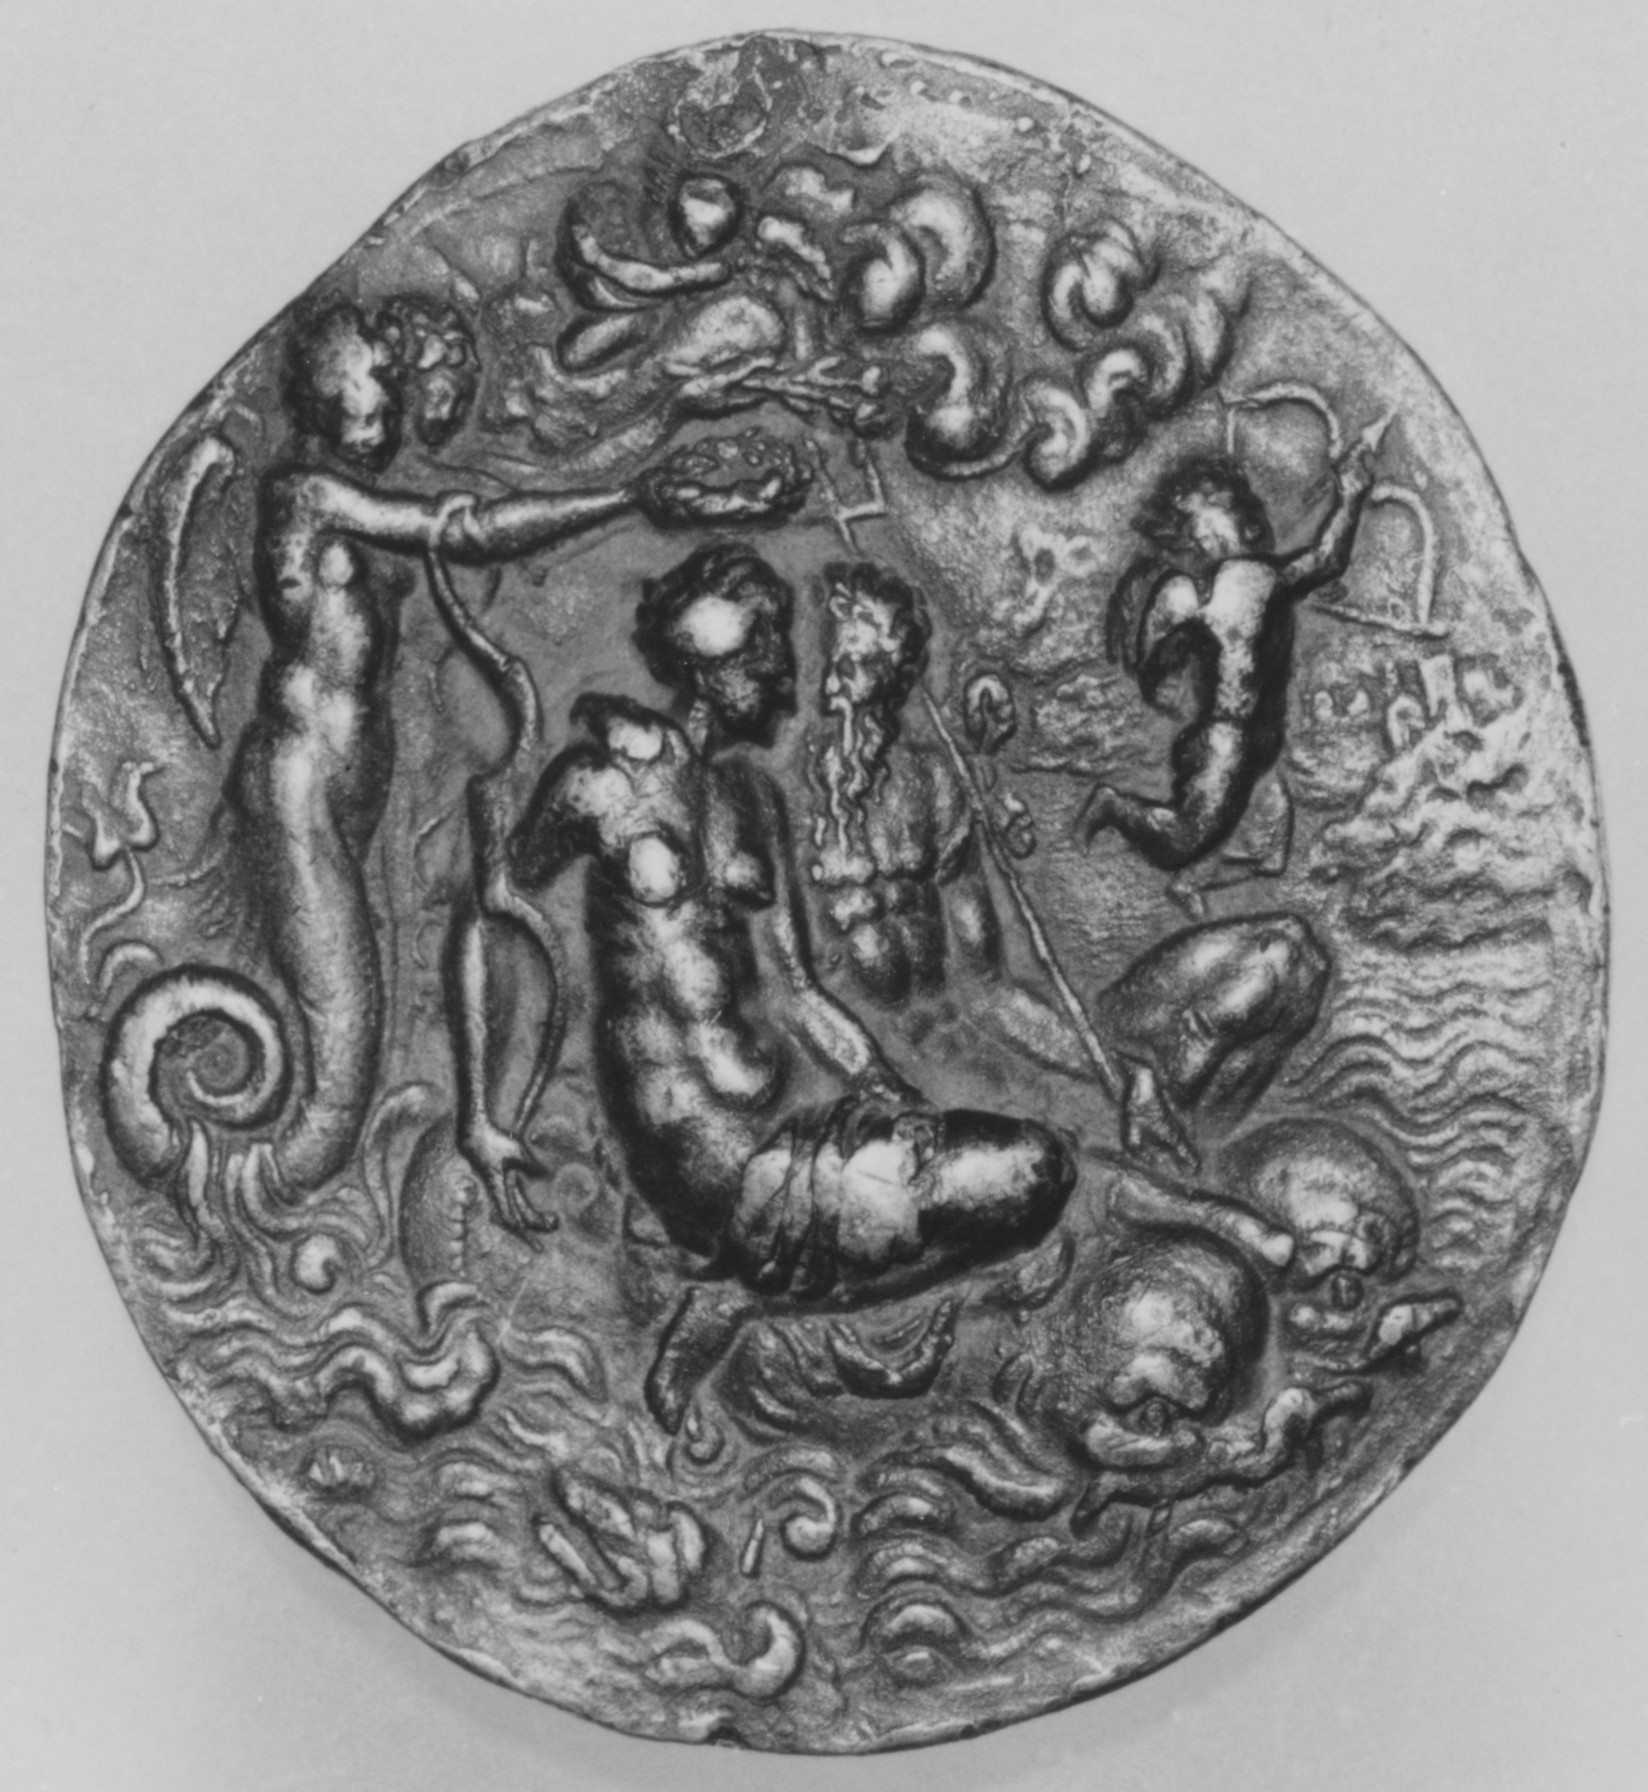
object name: plaquette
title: Neptune and Amphitrite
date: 1501-1600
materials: lead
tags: cupid,mermaids,neptune